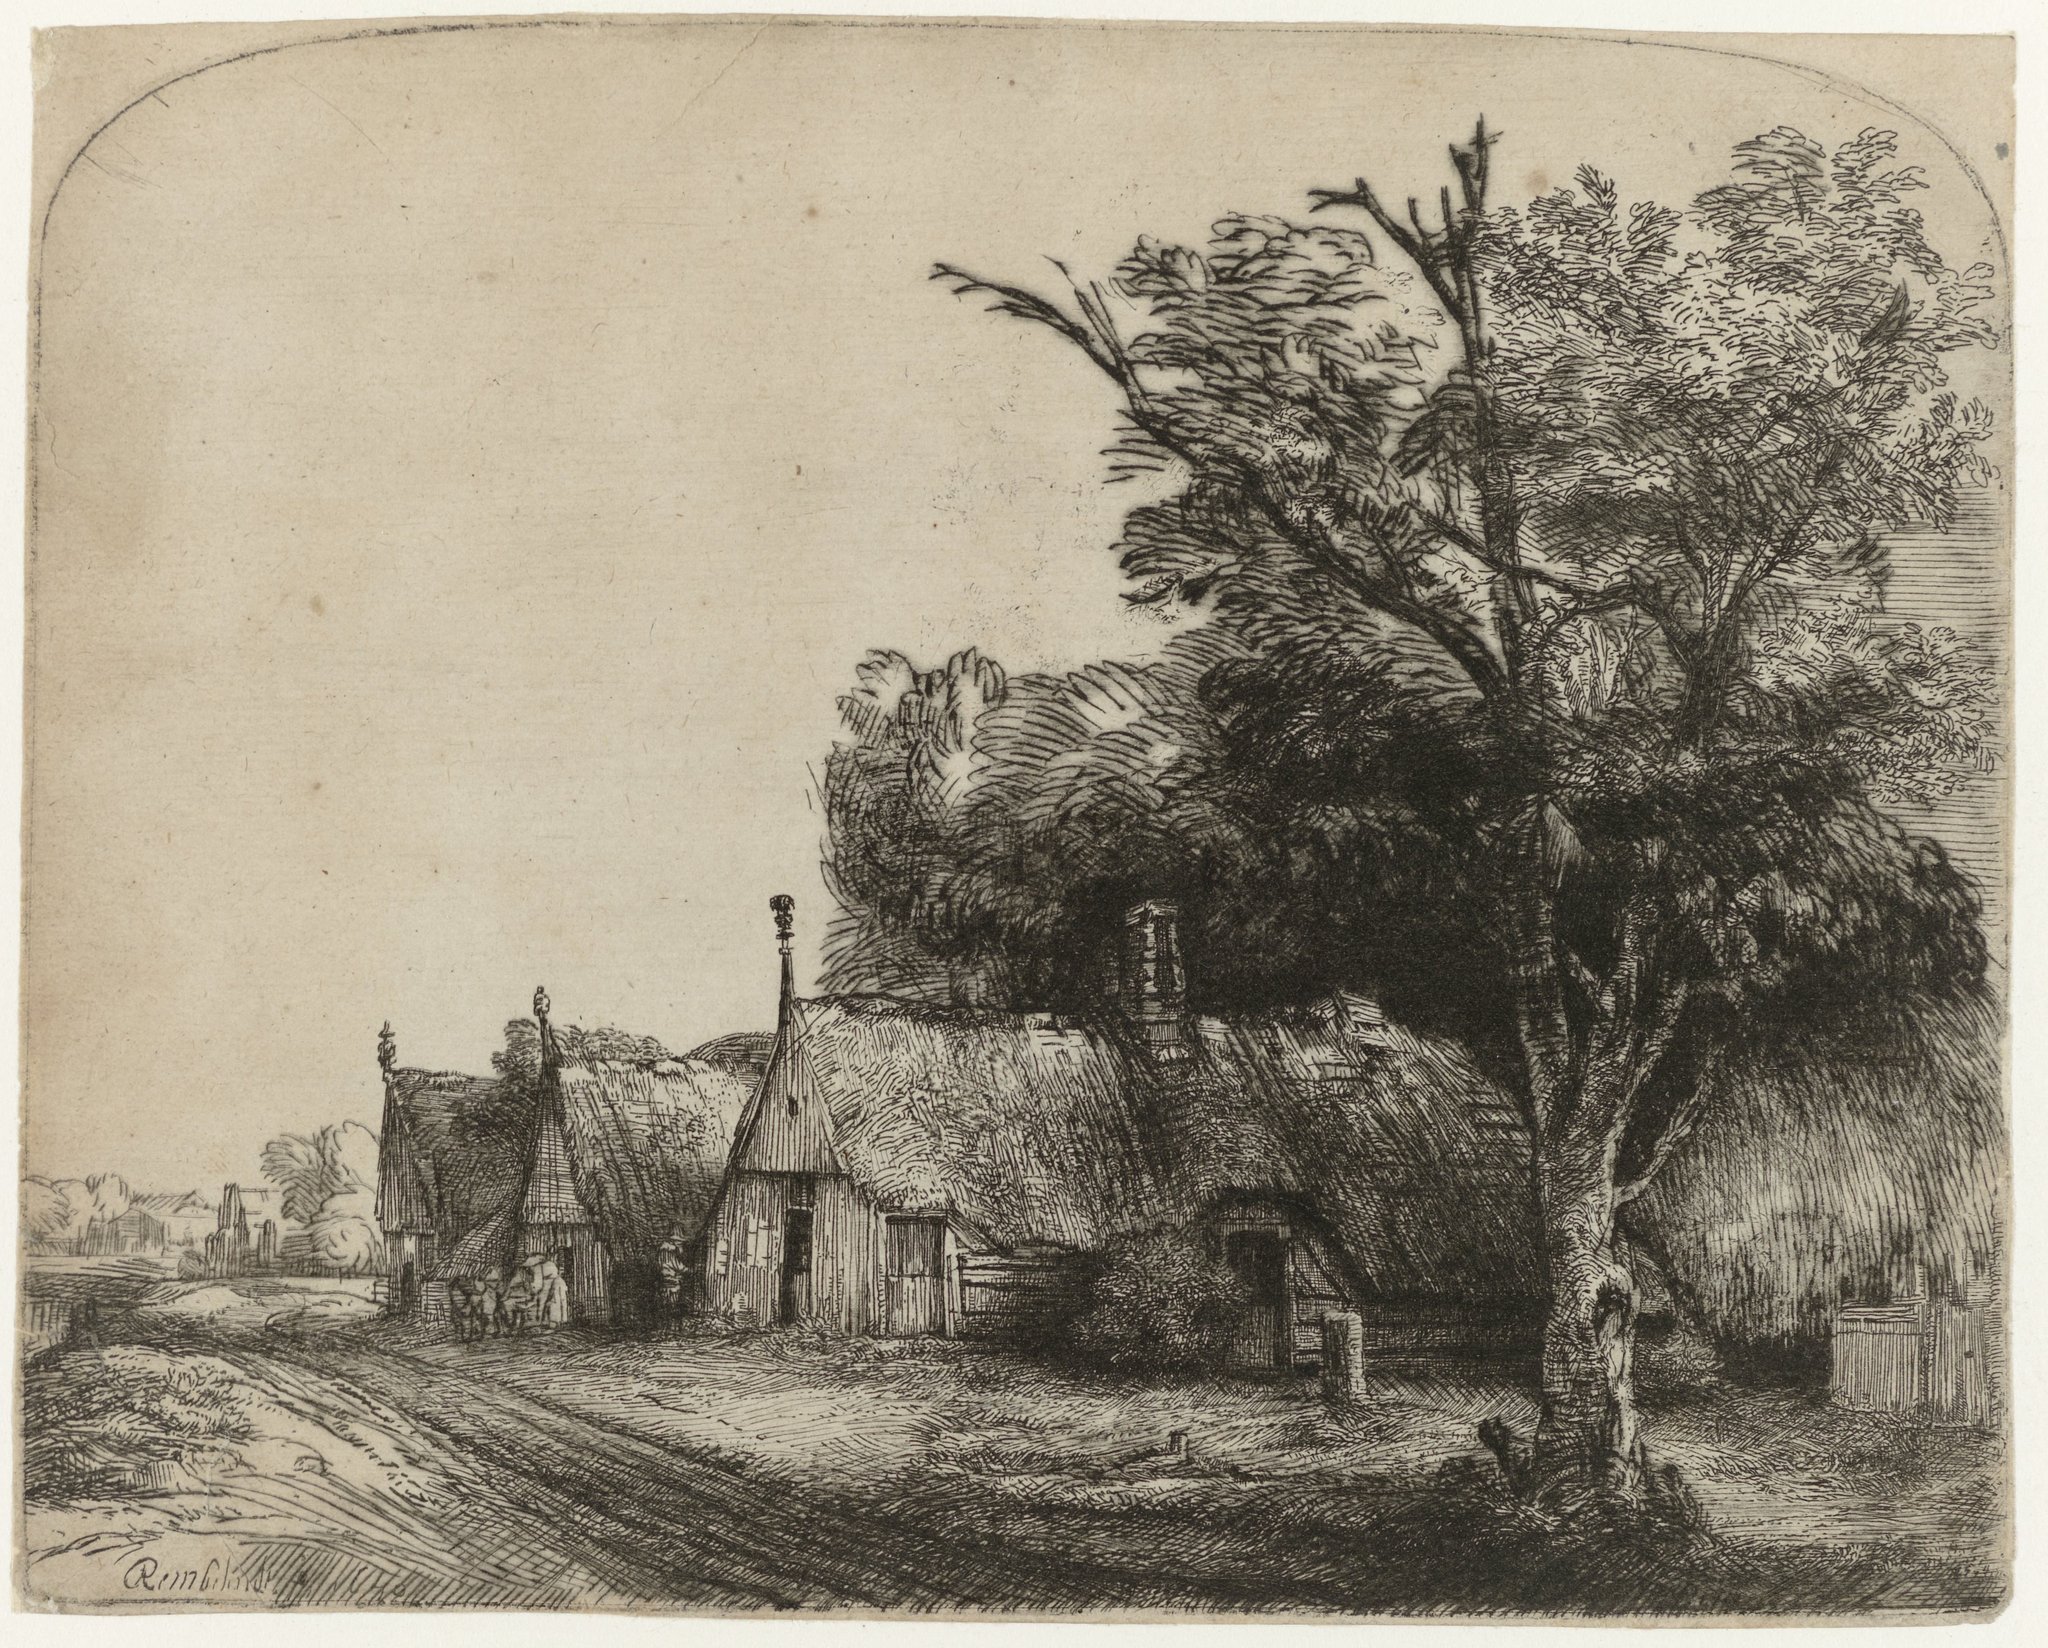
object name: print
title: Landscape with Three Cottages along a Road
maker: rembrandt van rijn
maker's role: draughtsman, painter, print maker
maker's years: 1606-1669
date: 1650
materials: paper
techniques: drypoint, etching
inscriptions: : Lugt 240, collector's mark: Lugt 58, signature and date: ‘Rembrandt f 1650’, collector's mark: Lugt 2228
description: As his career moved into its later phase, Rembrandt began to create more landscape etchings. In many cases, the location is easy to recognize. These cottages stood southwest of Amsterdam along the Schinkelweg. In fact, he was not overly concerned about topographical accuracy. The houses behind the first cottage are a rather free interpretation of the actual buildings.